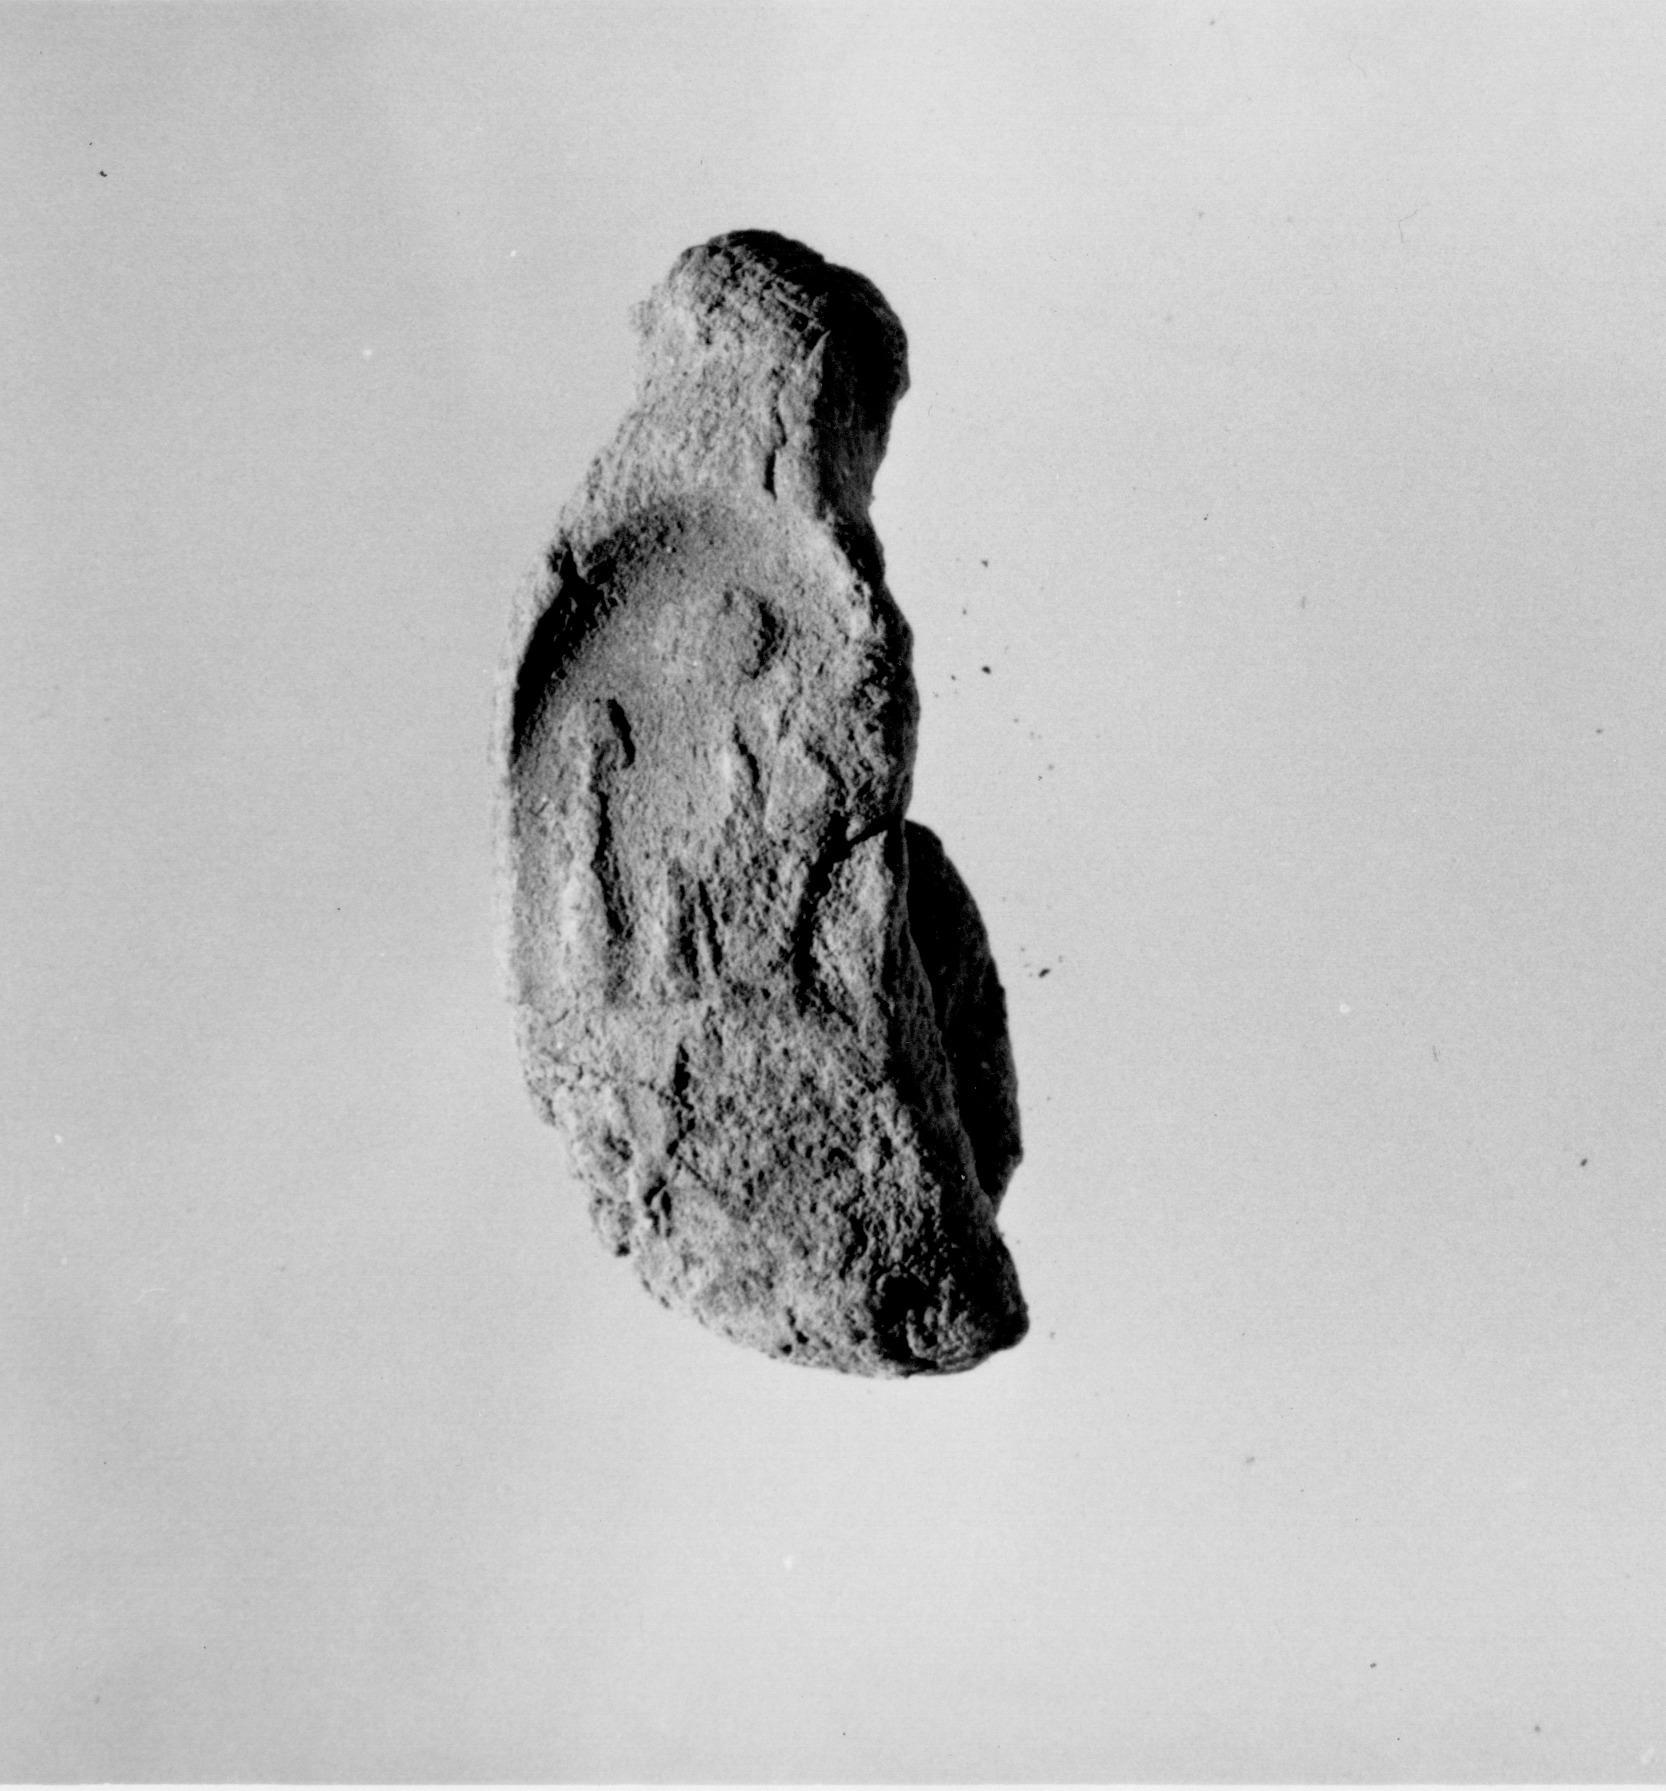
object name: sealing, nebmaatre, amenhotep iii, ptah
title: Document Sealing With the Throne Name of Amenhotep III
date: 1390-1352 BCE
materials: mud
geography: egypt